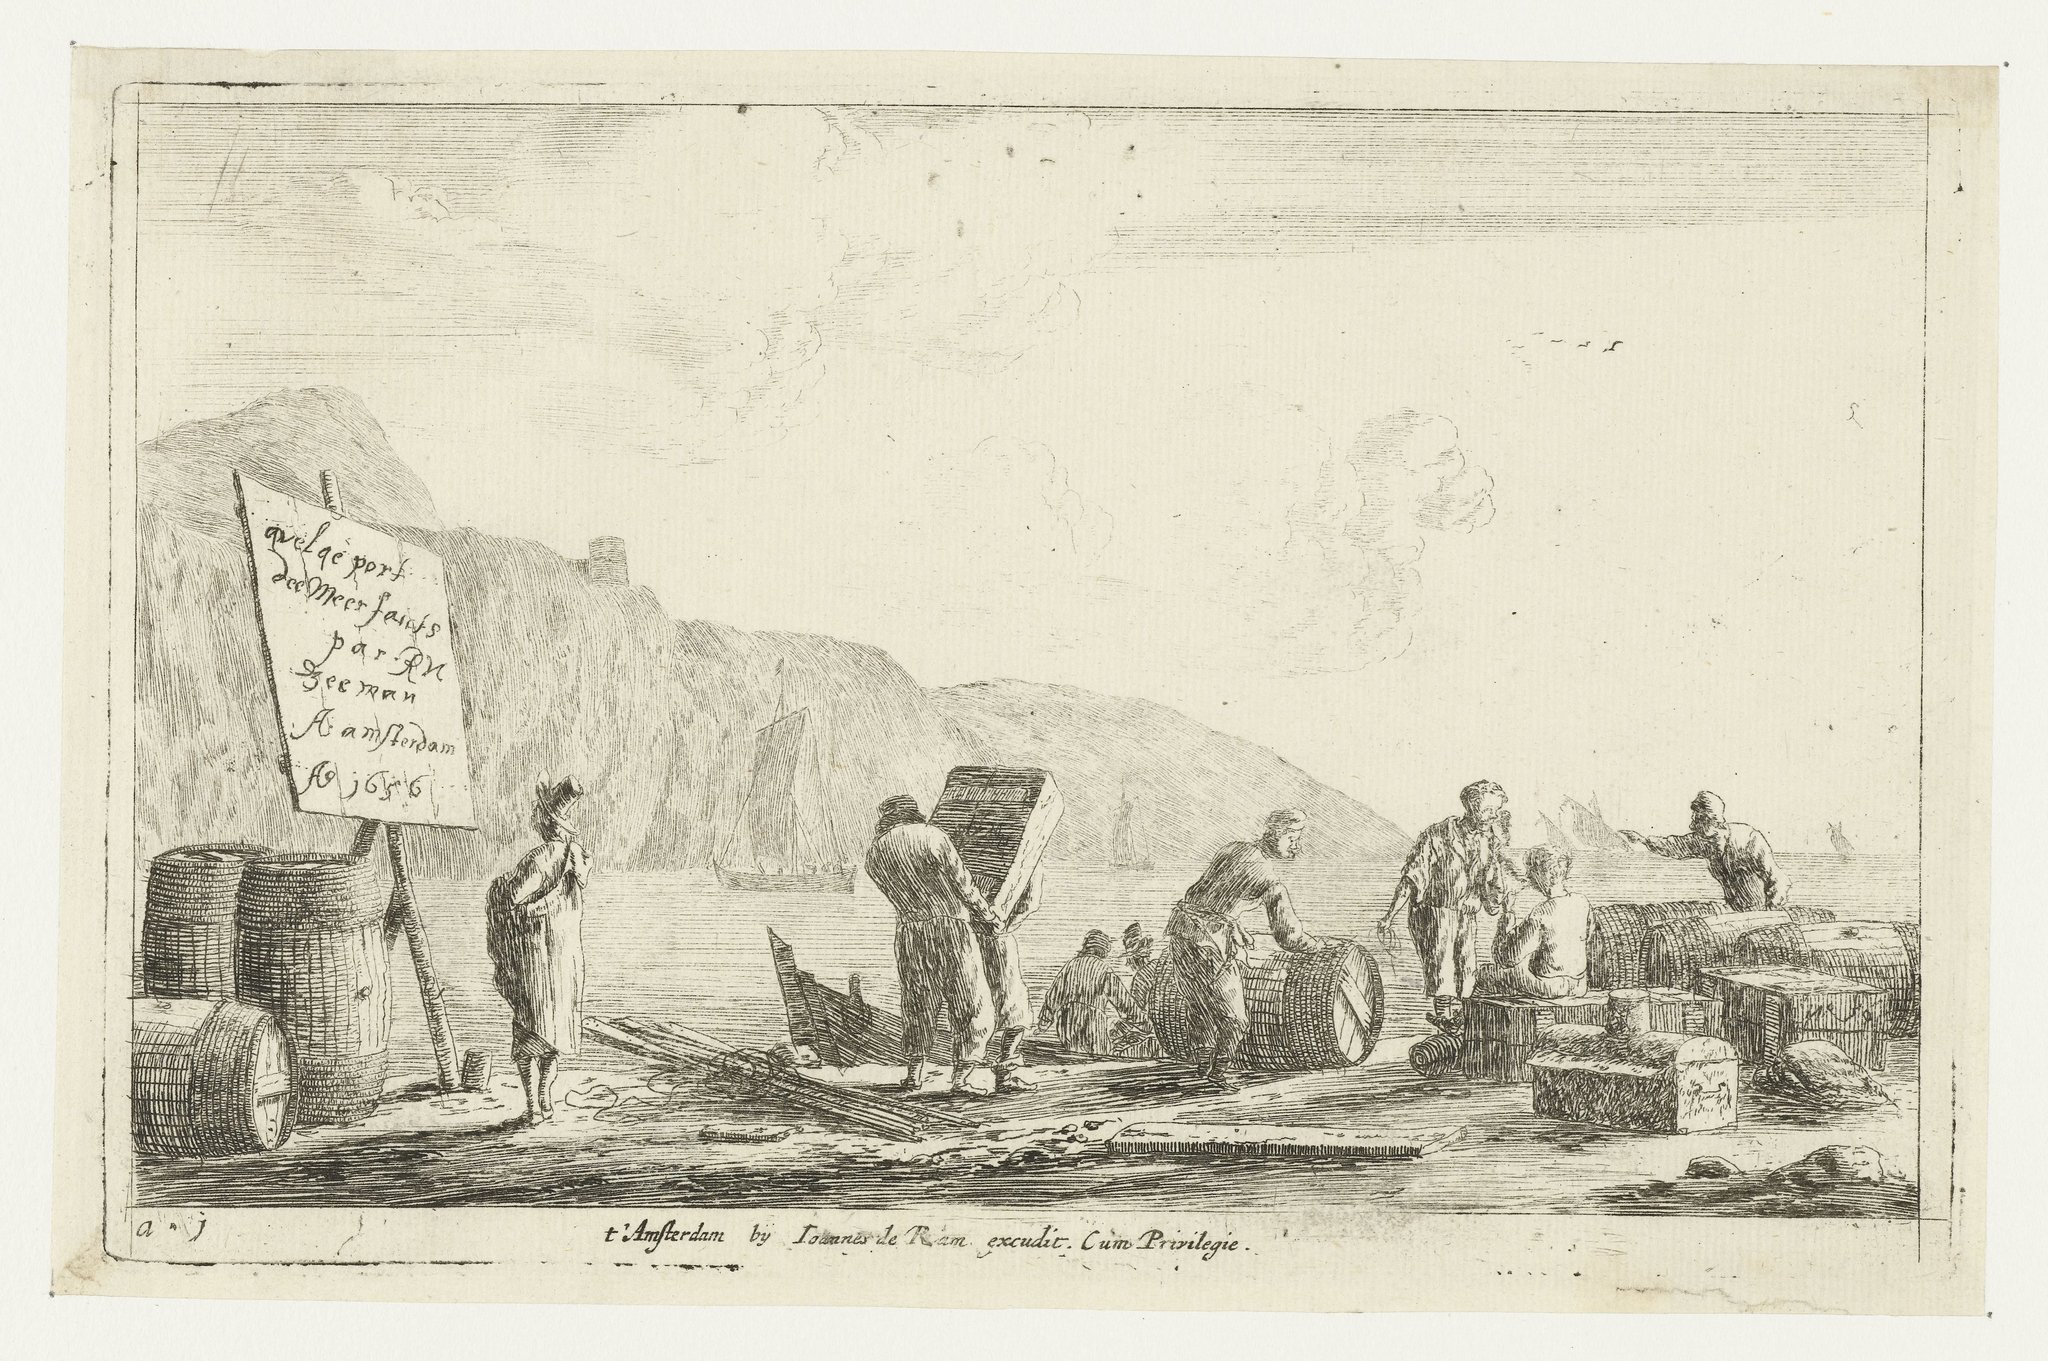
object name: titelprent, frontispice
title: Enkele zeehavens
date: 1656-1693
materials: paper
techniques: etching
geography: amsterdam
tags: seaman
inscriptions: date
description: Titelblad van een serie van acht prenten met zeehavens. Zeelieden en goederen op de kade